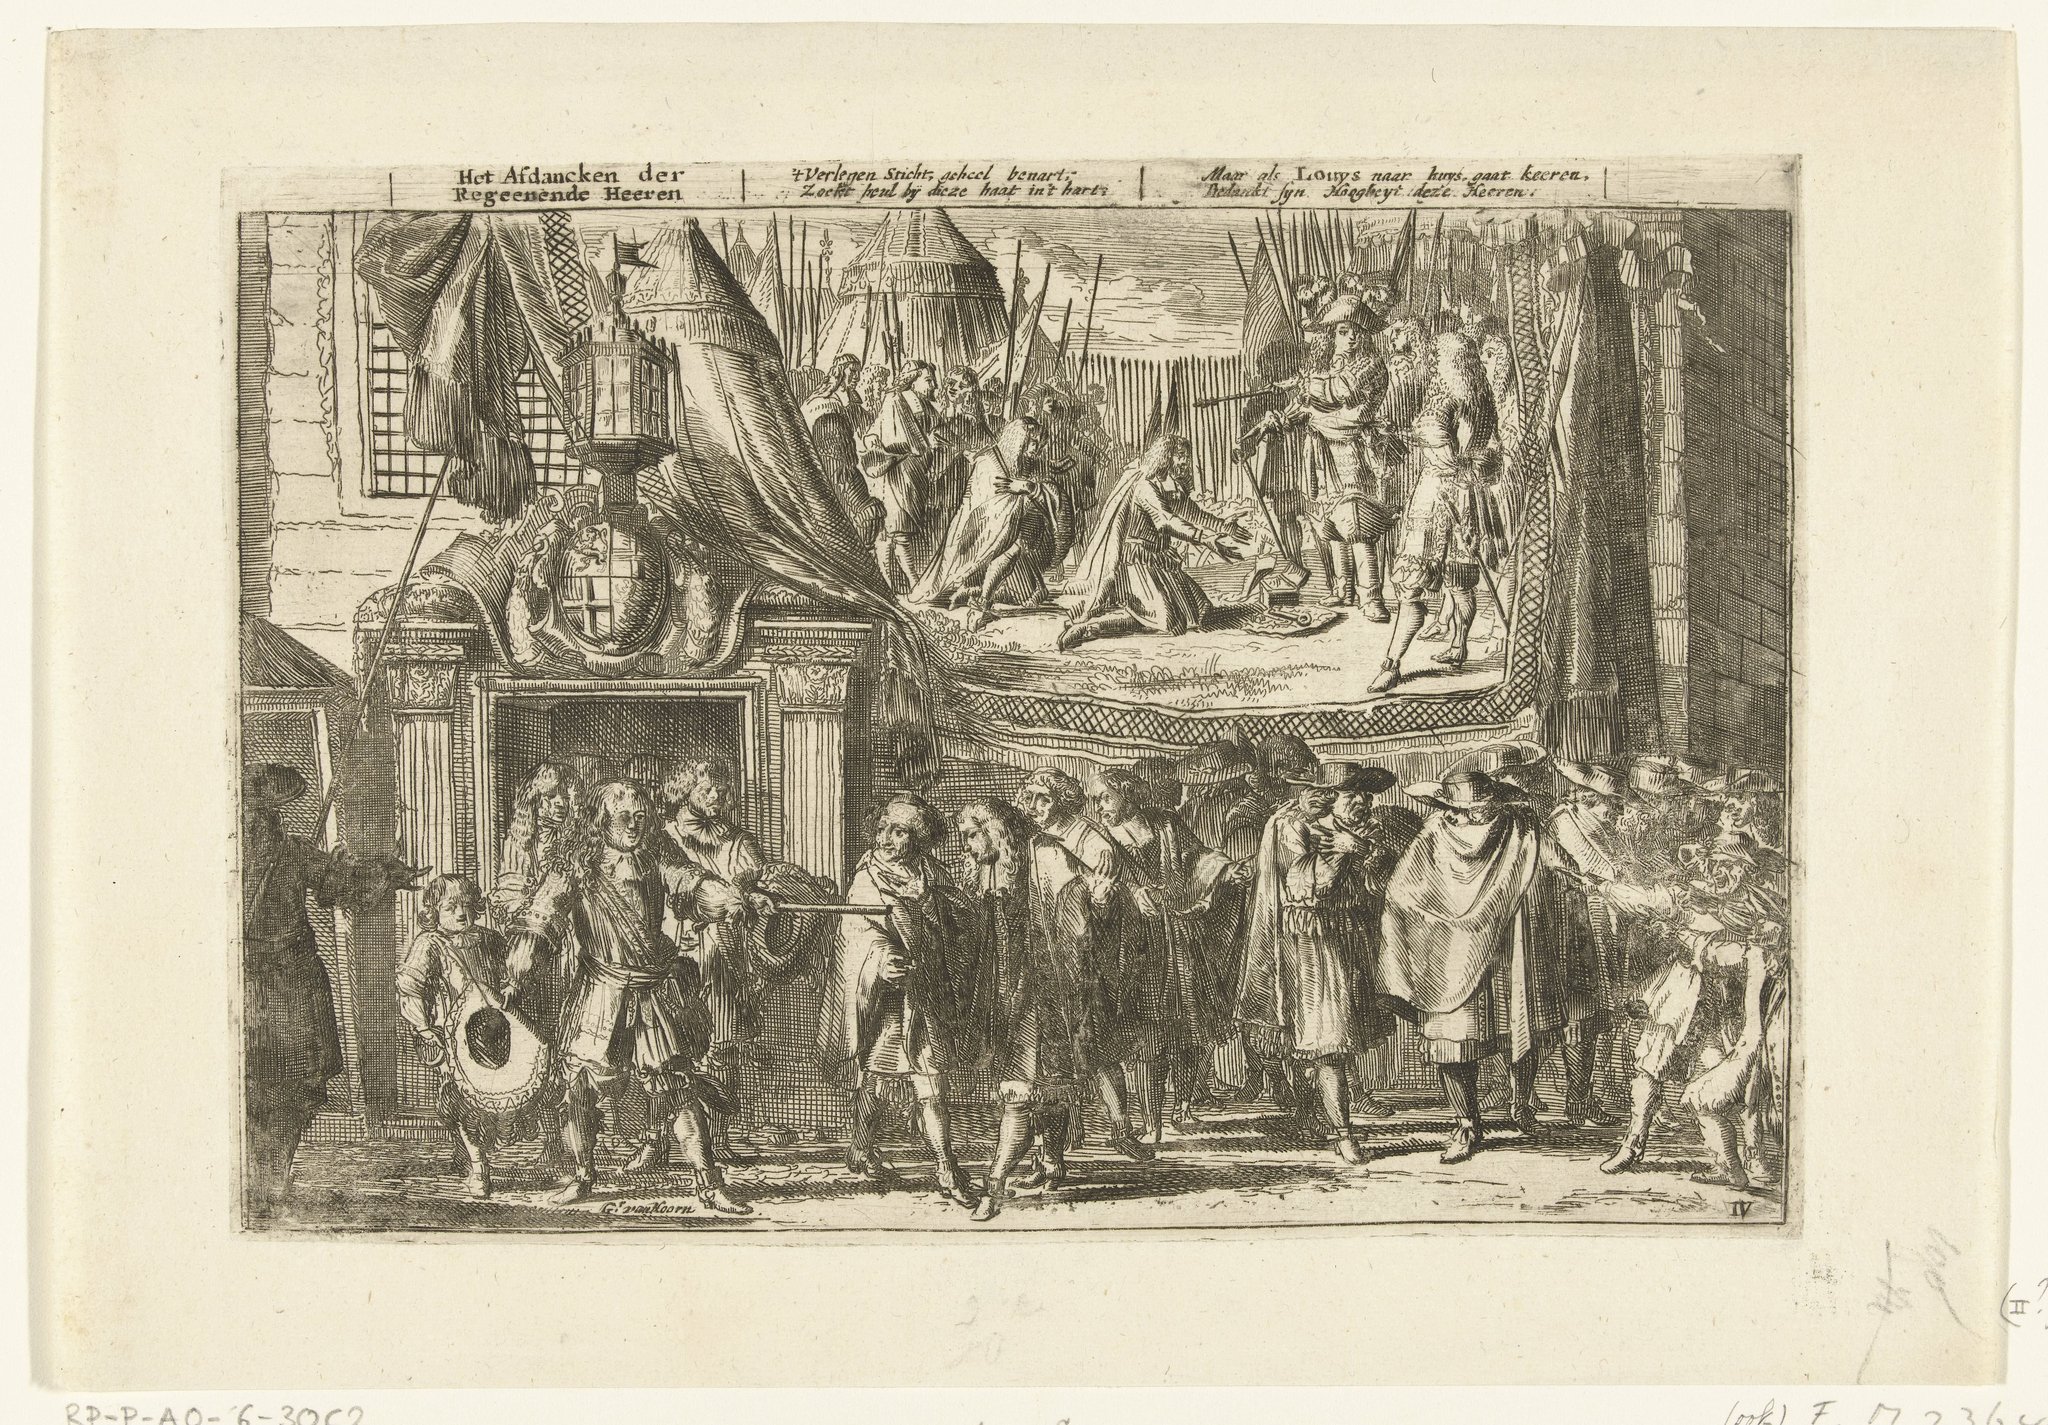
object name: history print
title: Het Afdancken der Regeerende Heeren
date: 1674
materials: paper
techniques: etching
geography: amsterdam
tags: utrecht, rampjaar (disaster year)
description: Reeks van vijf prenten over de gebeurtenissen voorgevallen in Utrecht over de periode 1672-74. In de vierde prent is te zien hoe na het vertrek van de Fransen uit de stad in 1673, de graaf van Hornes de leden van de vroedschap de laan uit stuurt. Boven deze voorstelling wordt in herinnering geroepen hoe het stadsbestuur de sleutels van de stad aan Lodewijk XIV had overhandigd.